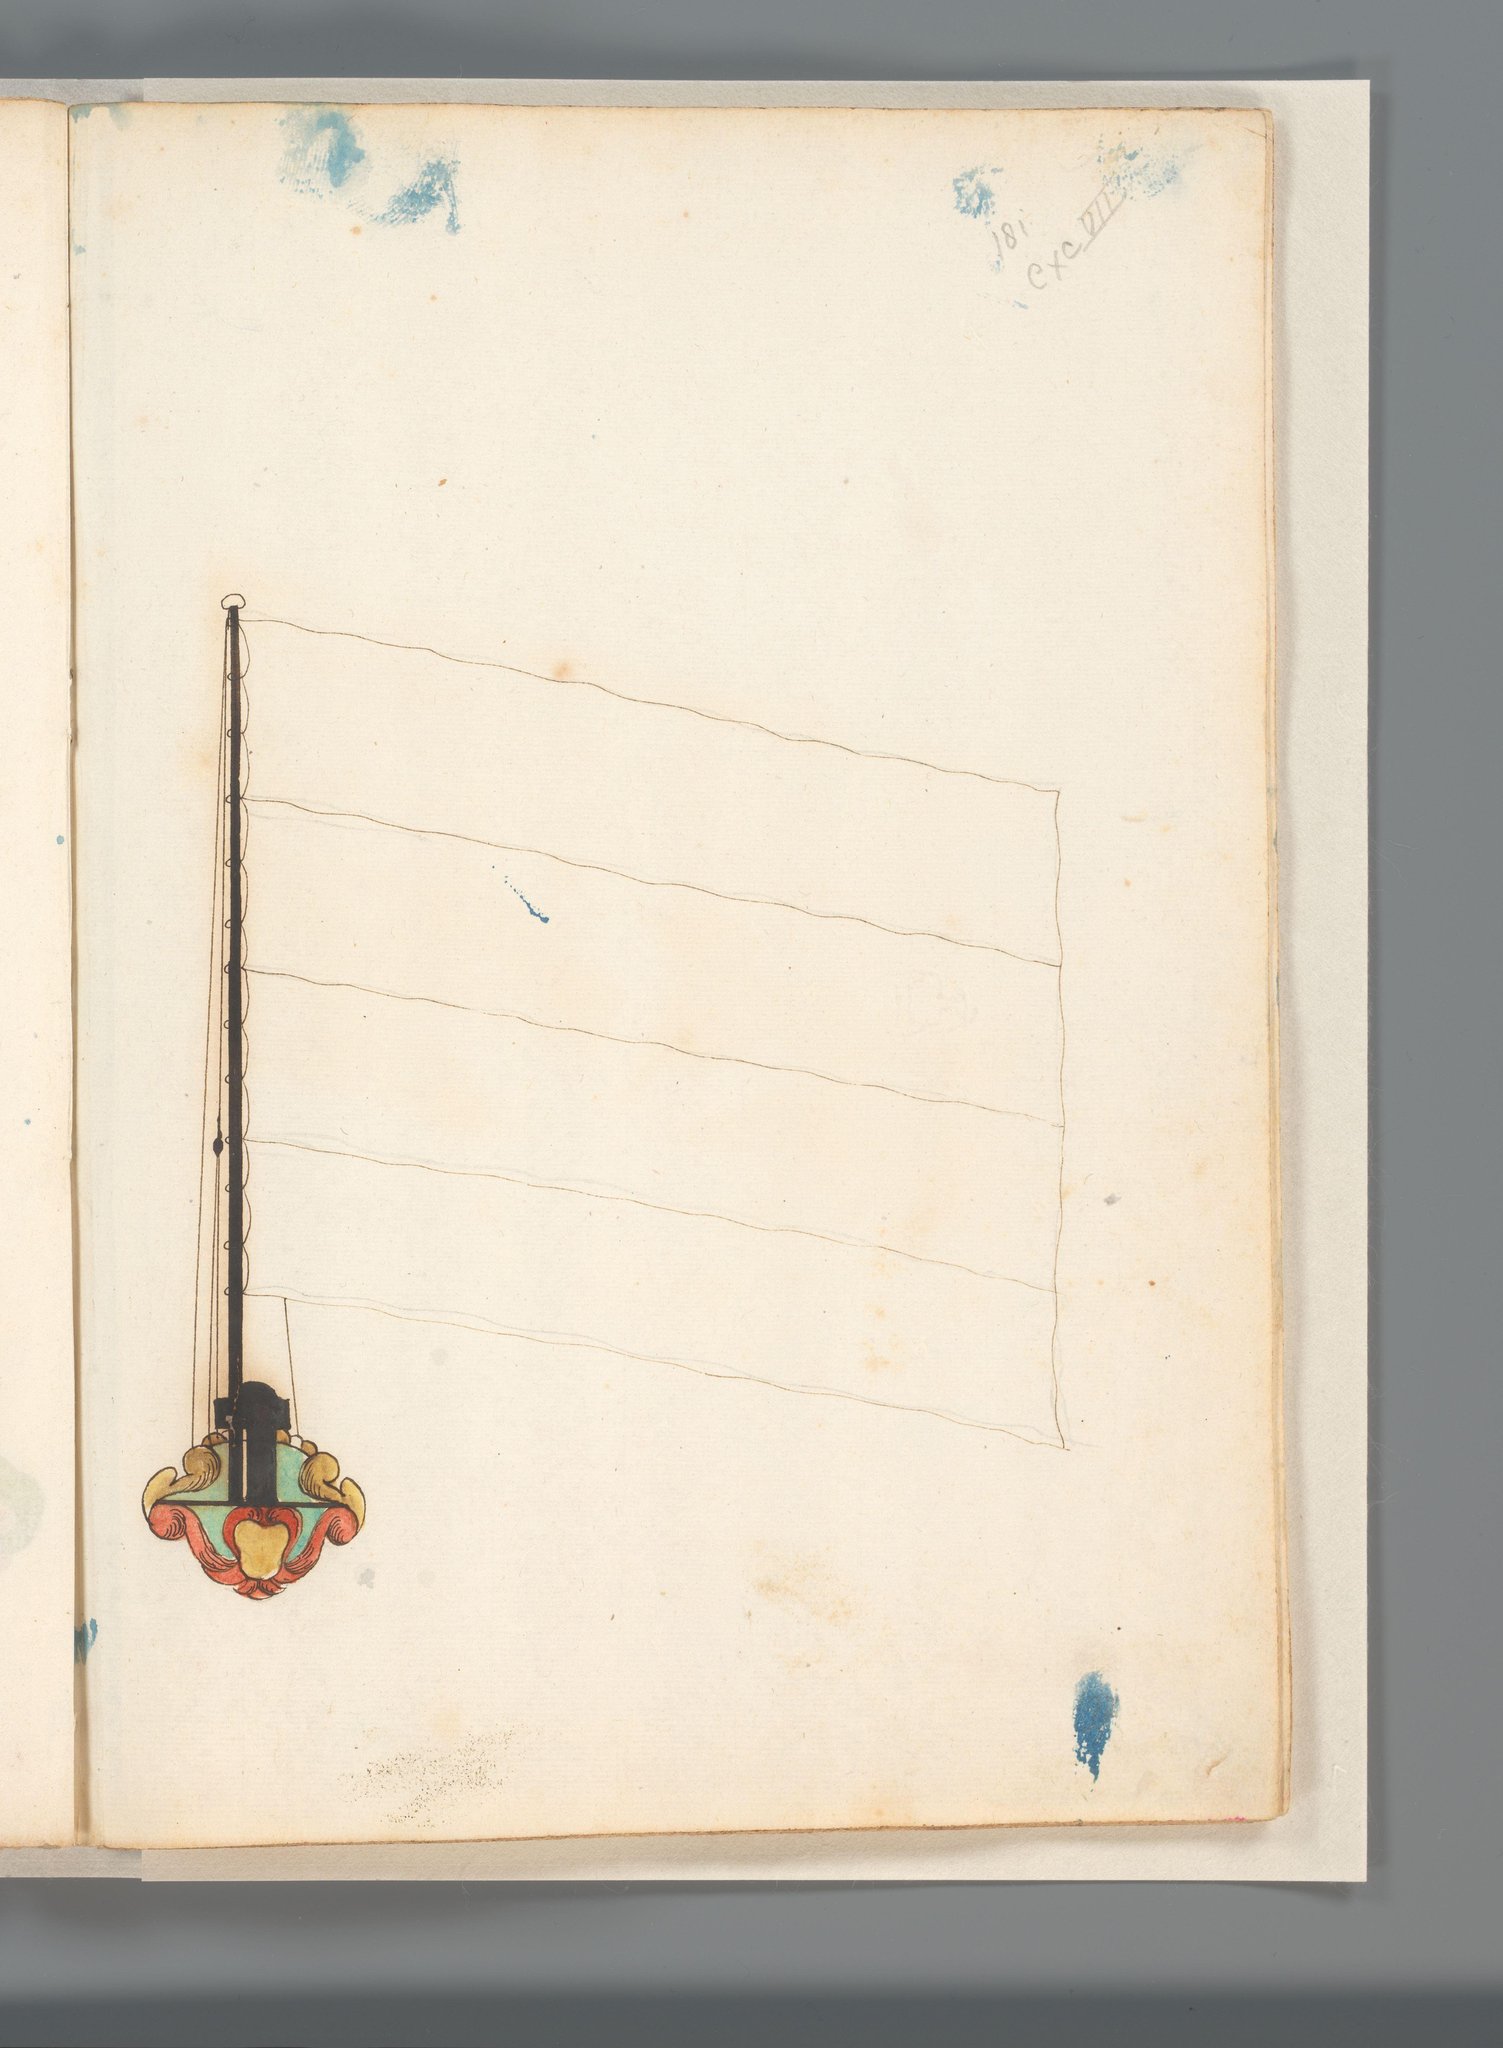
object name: drawing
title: Vlag van Stavoren (blanco)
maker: Anonymous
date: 1667-1670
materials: ink, paper, watercolor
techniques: brush, pen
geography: france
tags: flag, colours (as symbol of the state, etc.)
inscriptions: number: ‘181 / CXCVII / ...’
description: Blanco, oningevulde vlag, bestemd voor de vlag van de stad Stavoren. Vlag op vlaggensteng en mastvoet. Afgebeeld op folio 99r. Onderdeel van een vlaggenboek met vlaggen uit Europa, Noord-Afrika, Nabije en Verre Oosten.